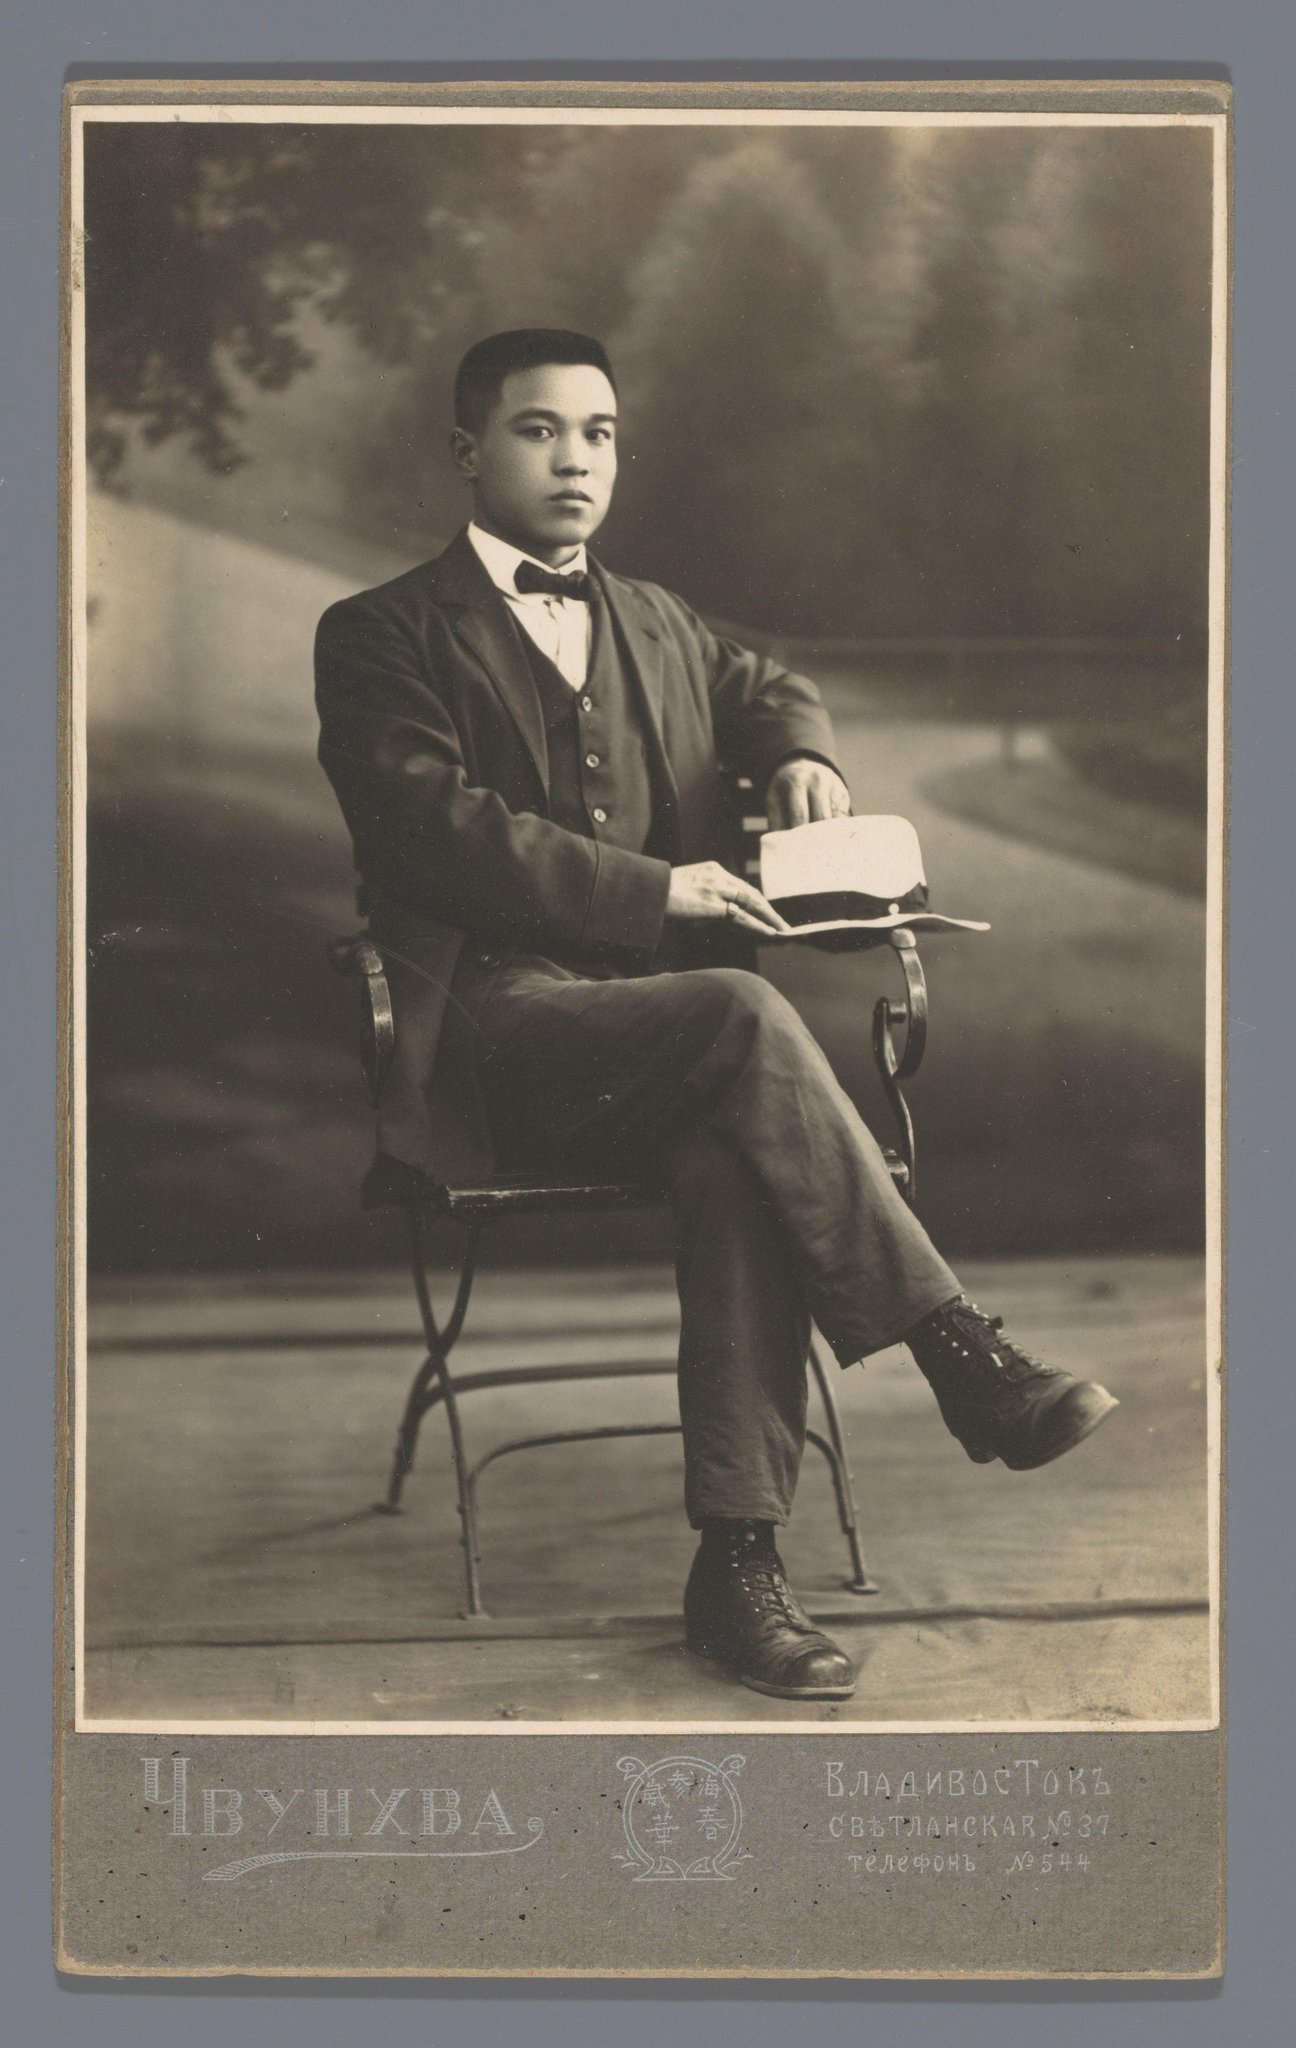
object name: photograph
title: Portret van een onbekende Aziatische man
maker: tsjvoenchva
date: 1910-1930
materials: paper, cardboard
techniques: gelatin silver print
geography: vladivostok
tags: adult man, anonymous historical person portrayed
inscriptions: address: ‘Владивостоке/ Светланская No 37/ телефонь No 544’, inscription: ‘Huronán/ Ban-uiu-ho [?]’